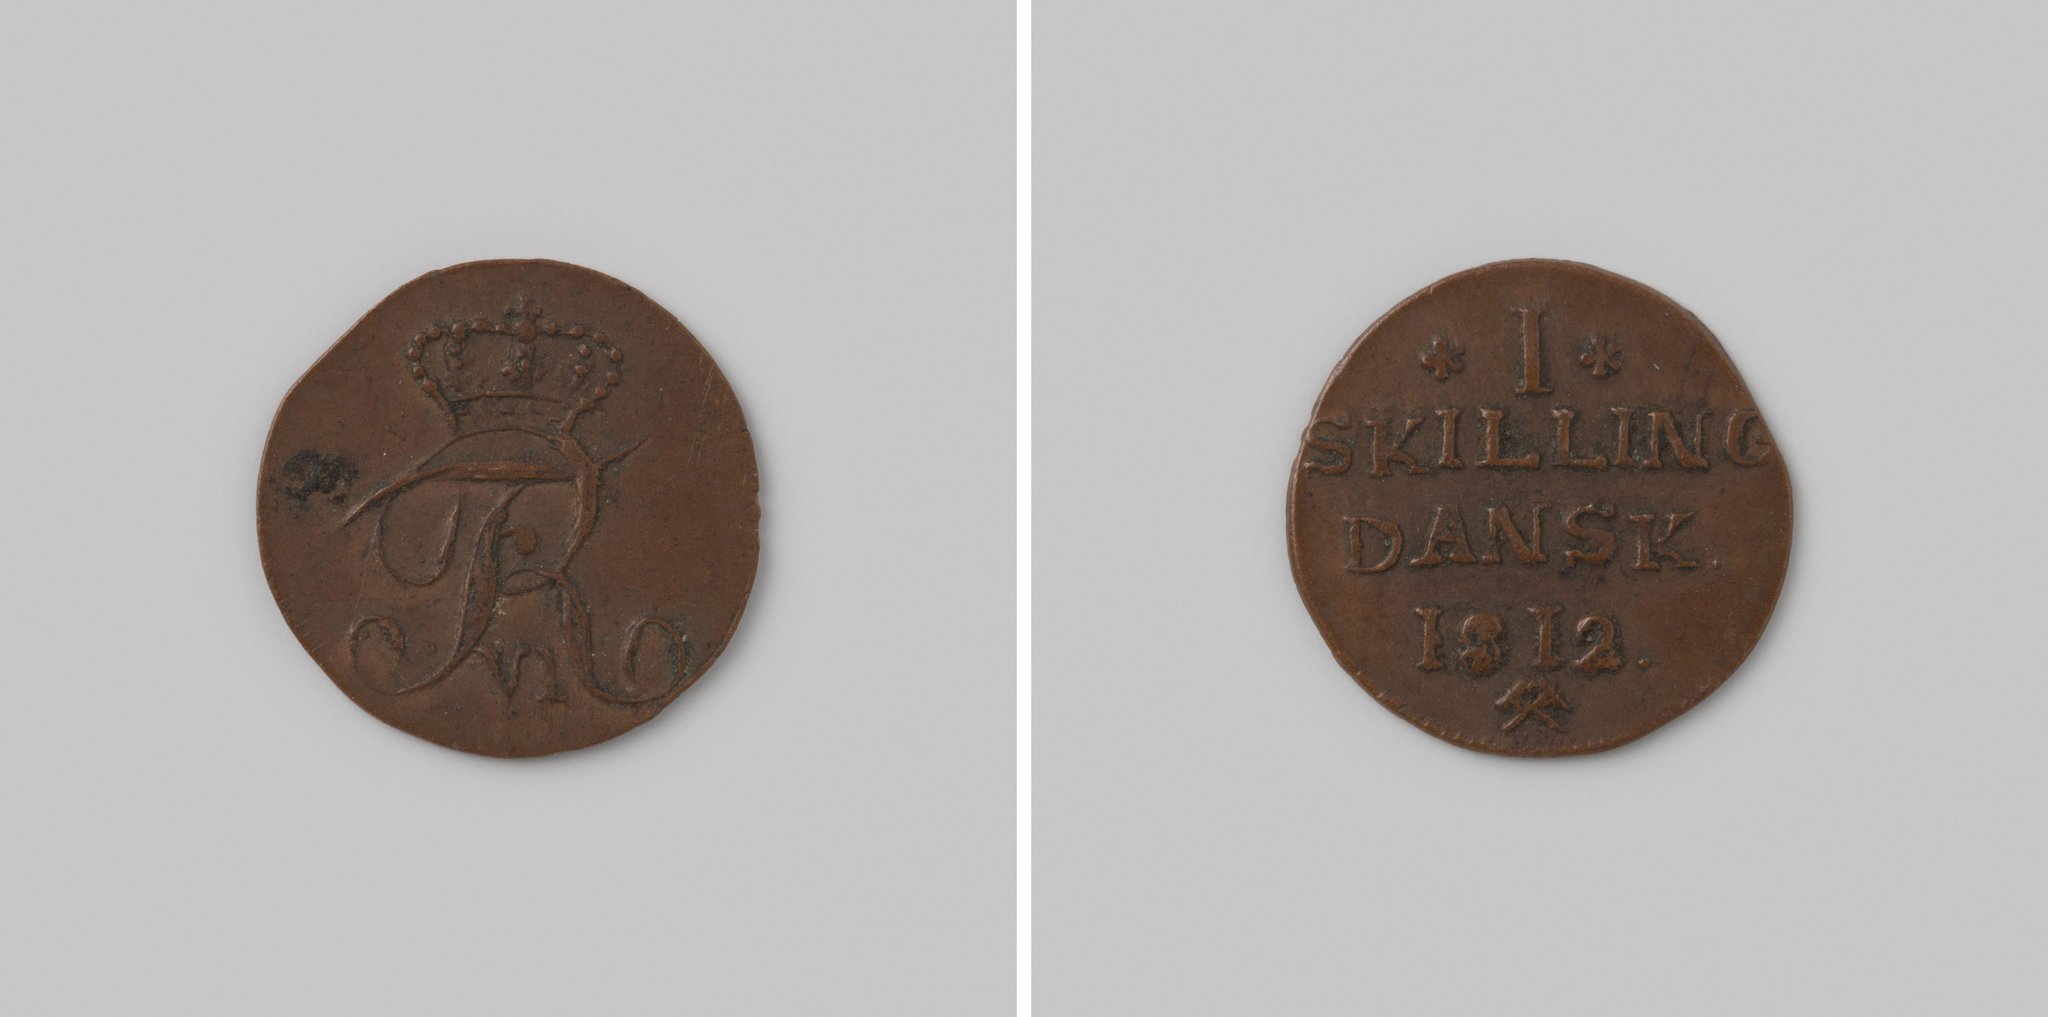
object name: coin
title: Noorwegen, Frederik VI, skilling dansk, 1812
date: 1812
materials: copper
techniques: striking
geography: kongsberg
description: Koperen munt. Voorzijde: gekroond monogram van de vorst. Keerzijde: waarde-aanduiding in drie regels. Daaronder jaartal, waaronder aanduiding van de muntplaats. Gladde rand.